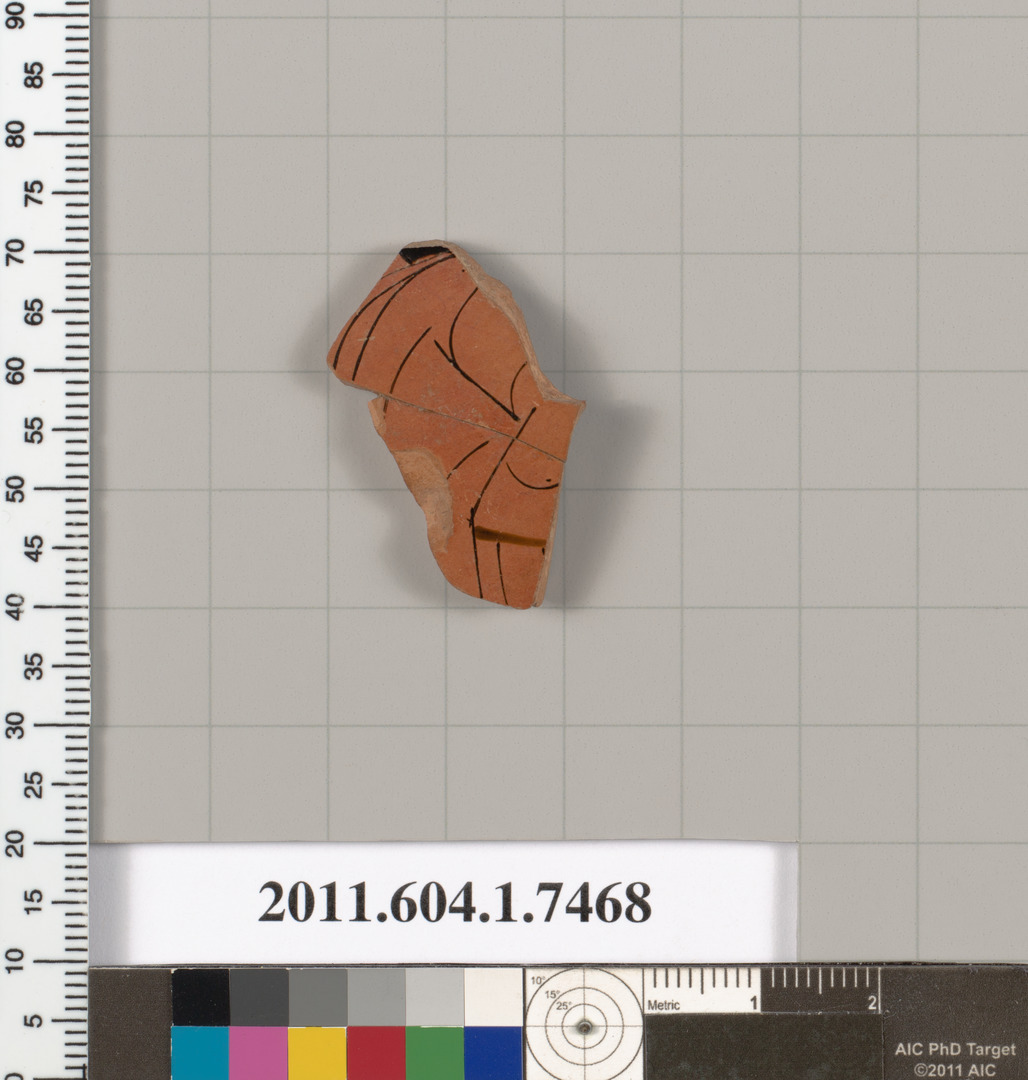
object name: kylix fragment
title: Terracotta fragment of a kylix (drinking cup)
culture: greek, attic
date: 470-460 BCE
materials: terracotta